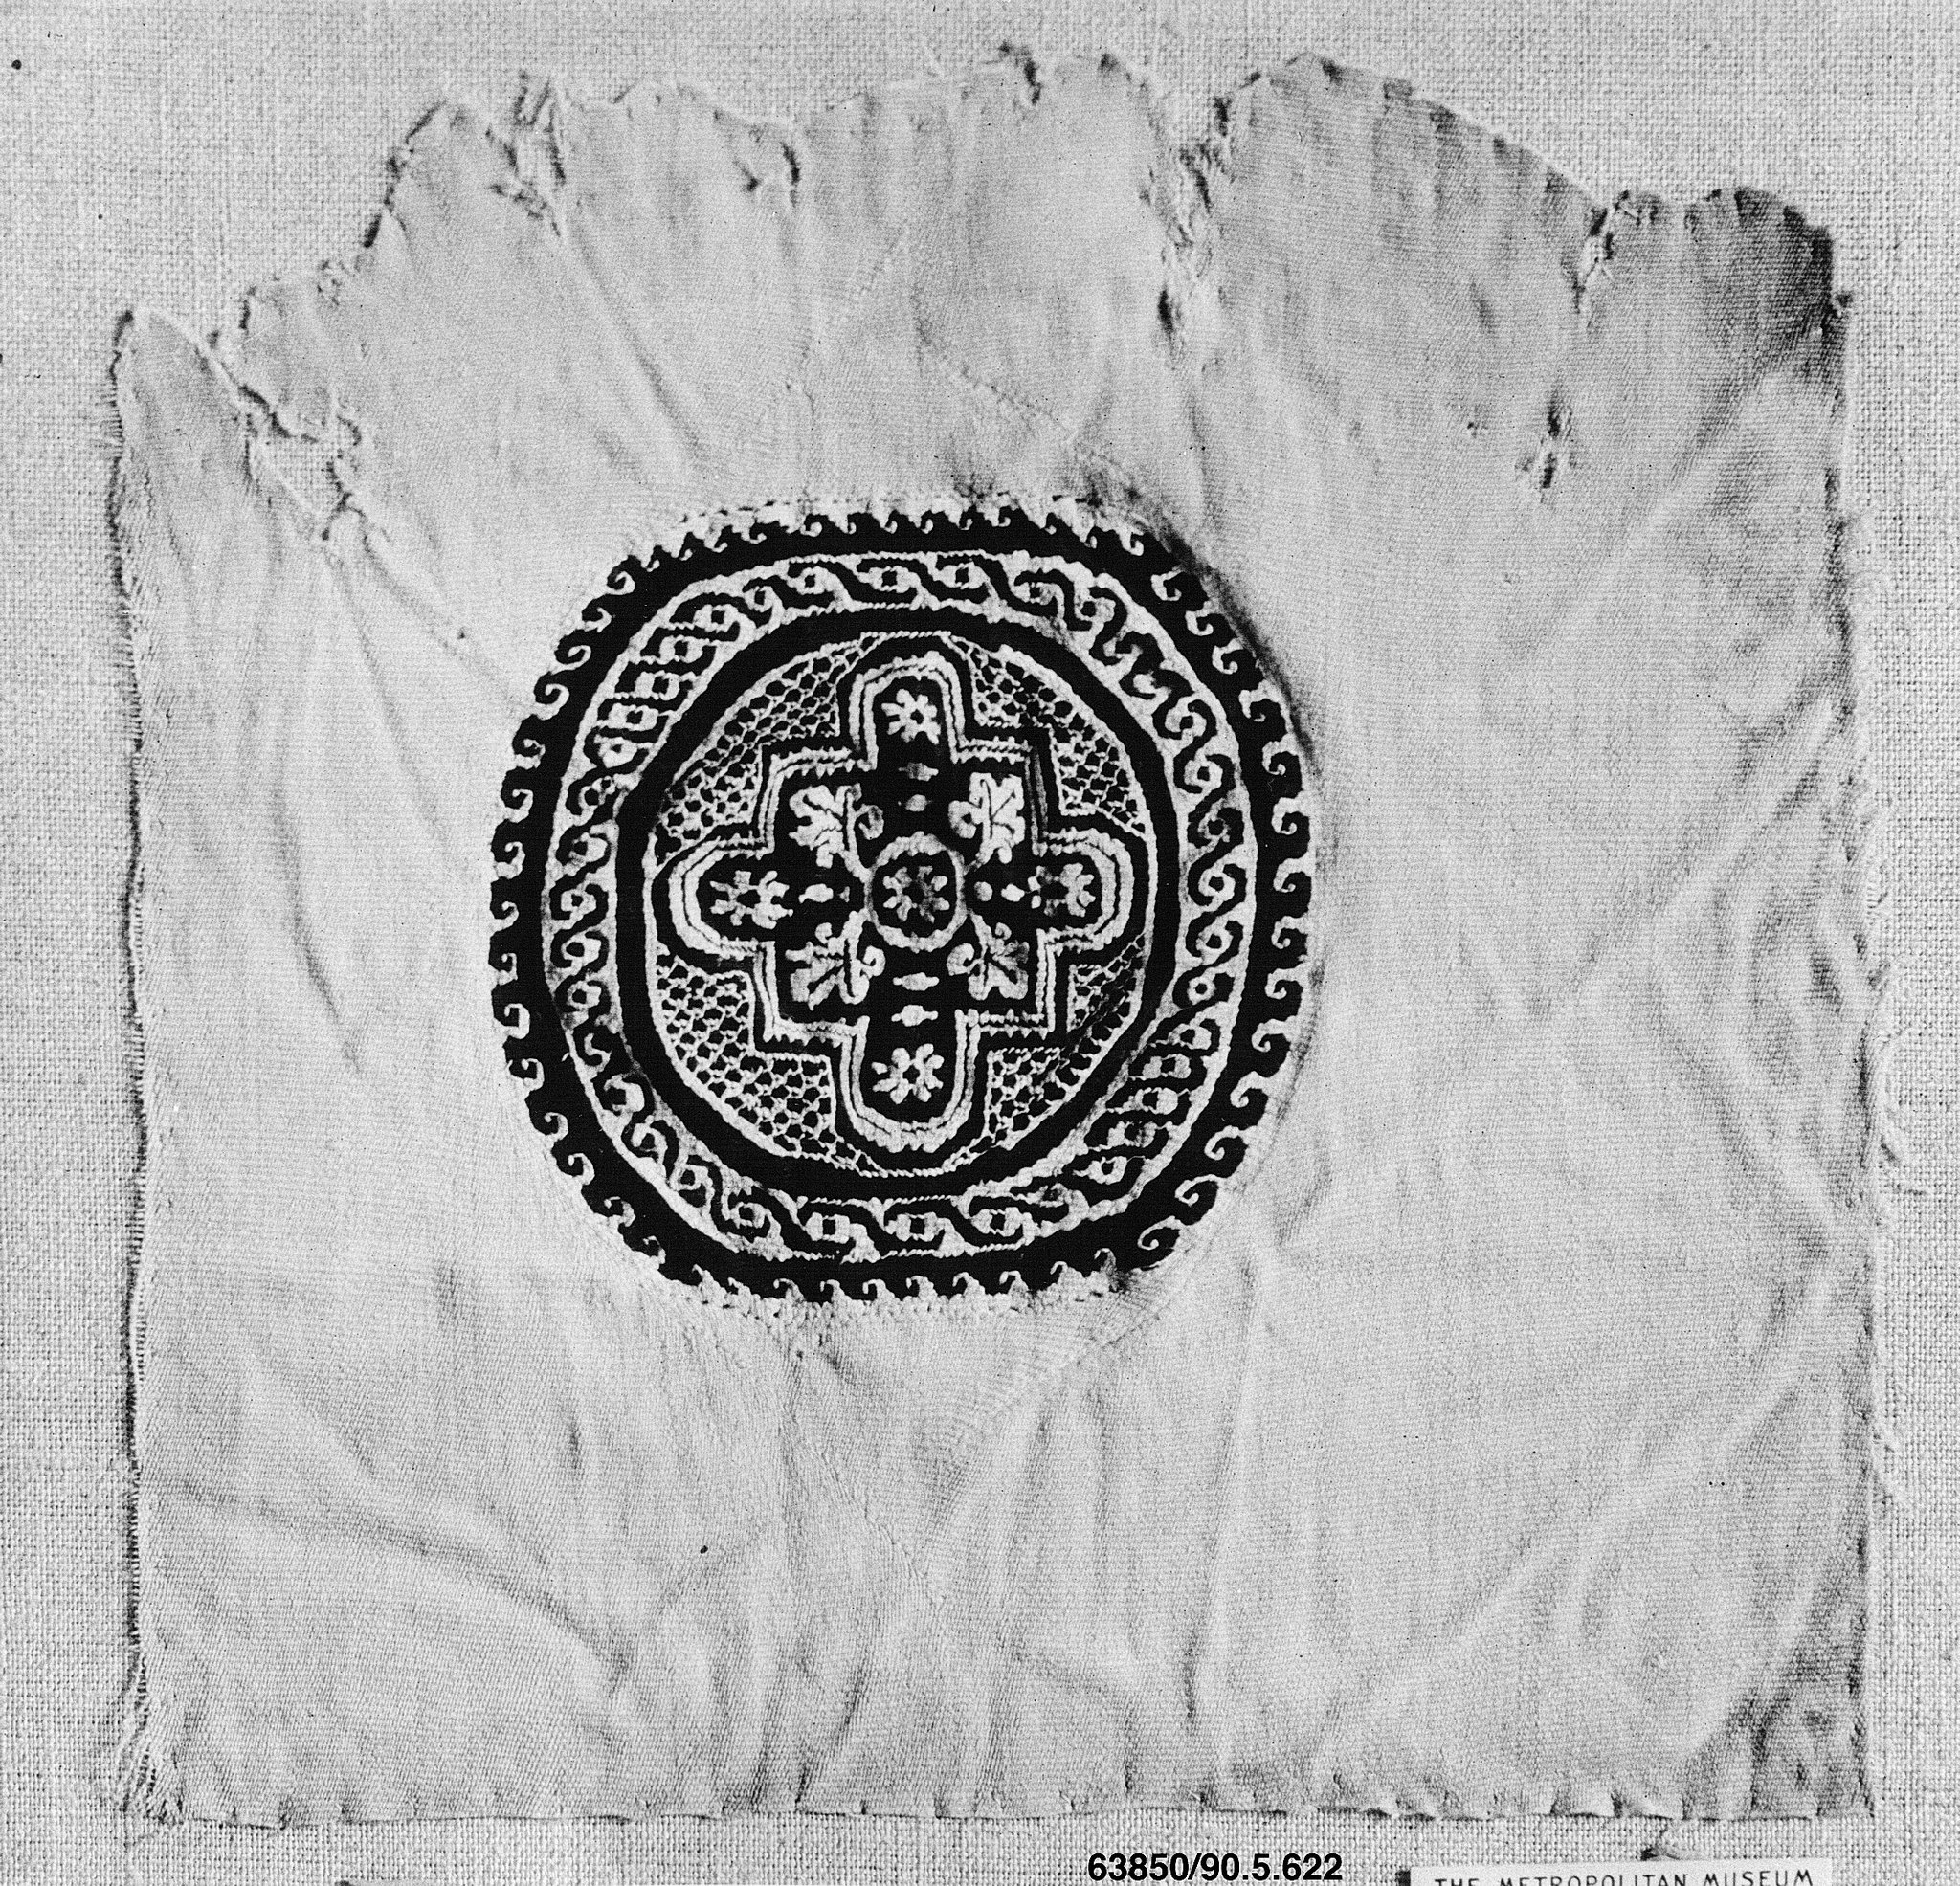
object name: textile fragment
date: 201-400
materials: linen, wool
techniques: weave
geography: egypt